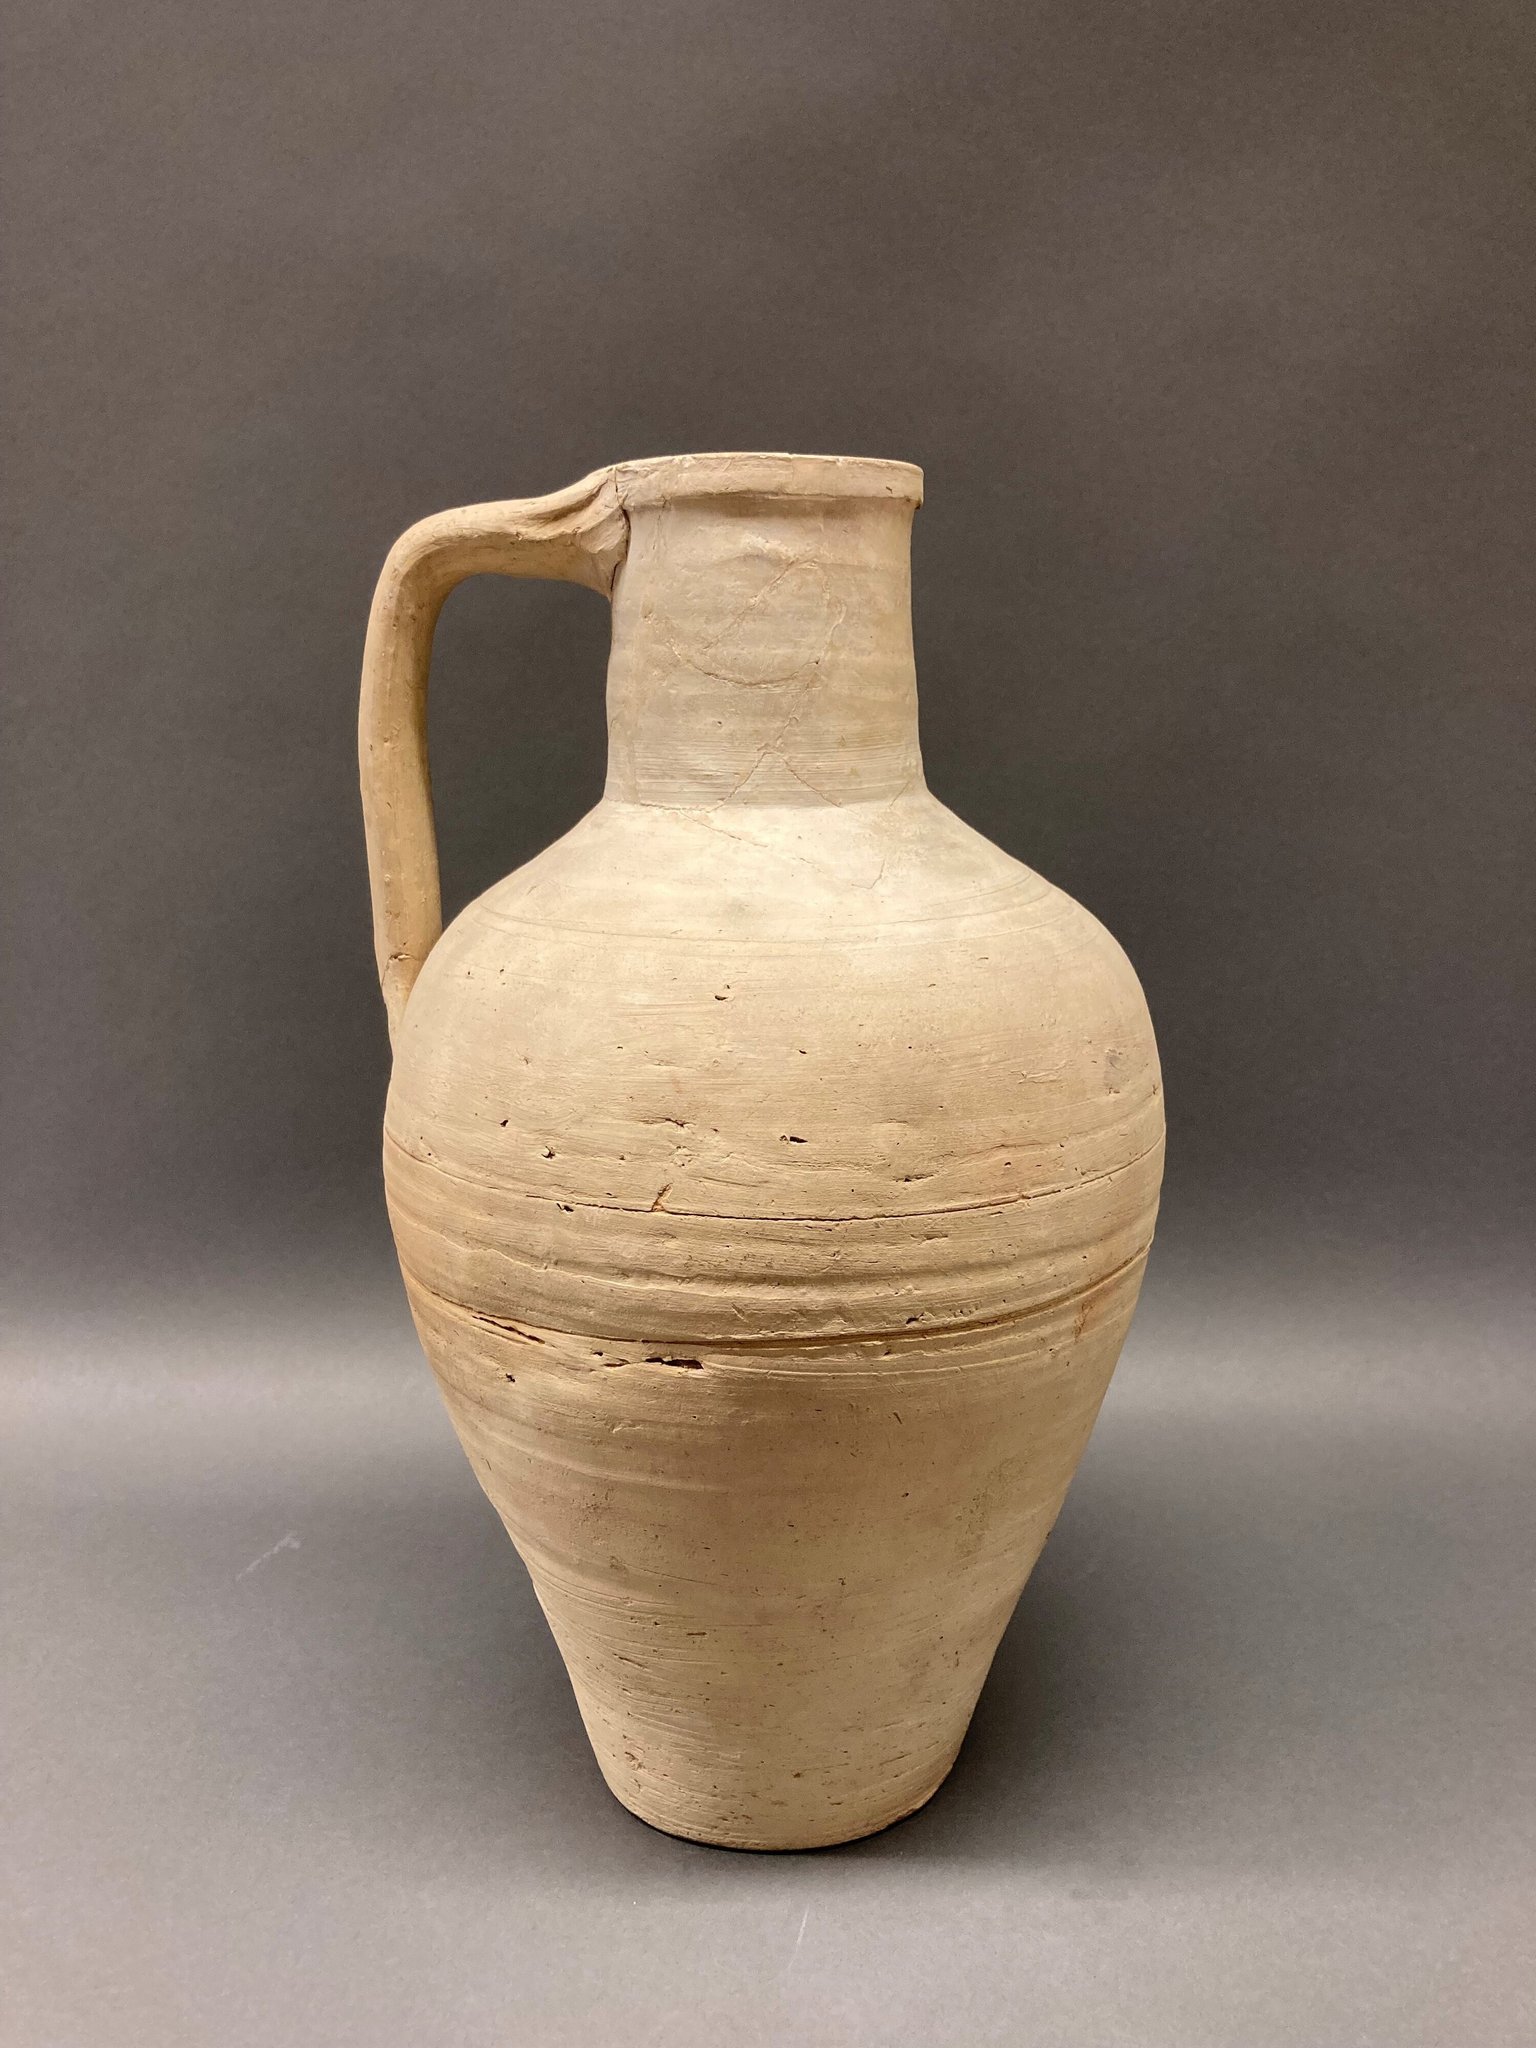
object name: ewer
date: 801-1000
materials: earthenware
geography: iran